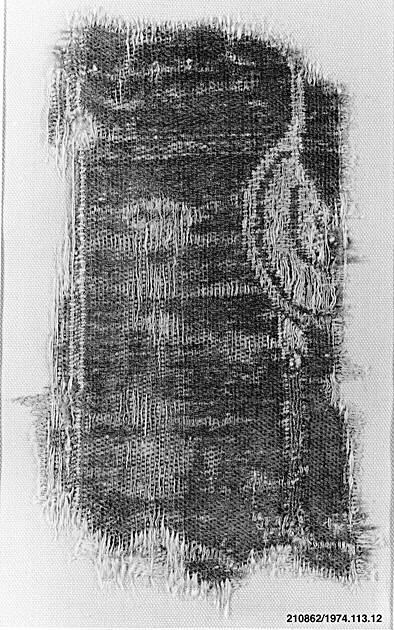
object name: textile fragment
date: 901-1100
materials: cotton, wool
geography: iran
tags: birds